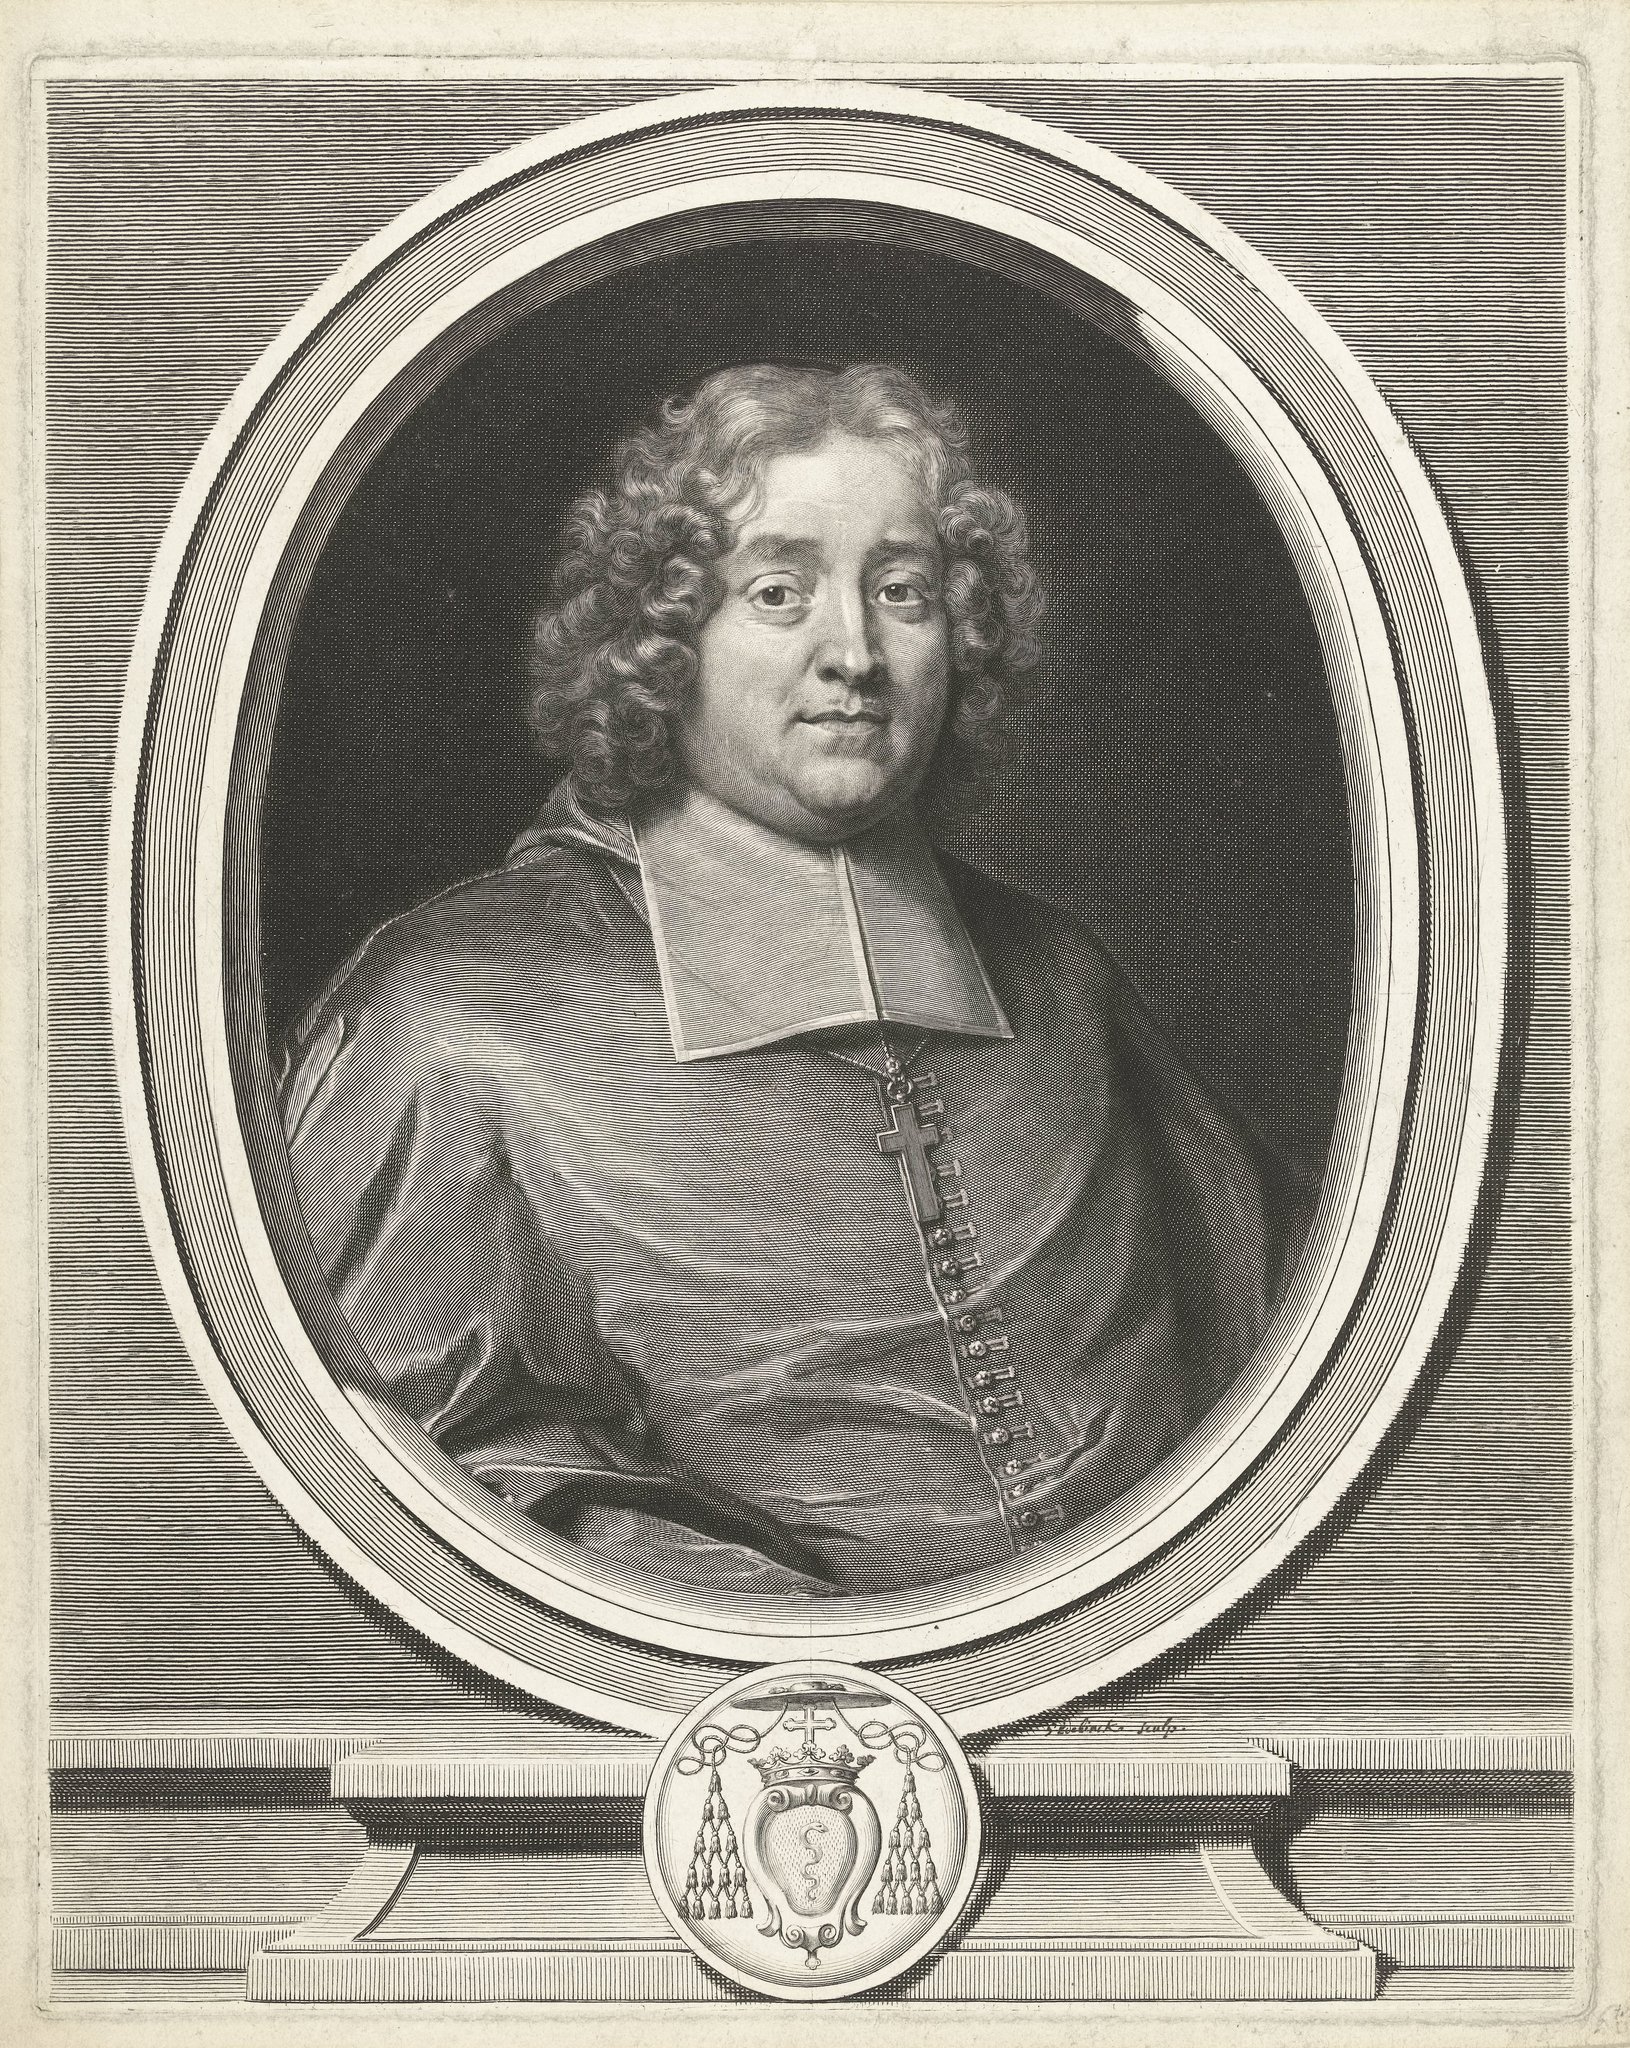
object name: print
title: Portret van Jean-Baptiste Michel Colbert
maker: gerard edelinck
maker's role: print maker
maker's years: 1640-1707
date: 1693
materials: paper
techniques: engraving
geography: france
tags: france, jean-baptiste michel colbert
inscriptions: collector's mark: Lugt 2228, inscription: ‘G Édelinck sculp.’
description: Portret van Jean-Baptiste Michel Colbert (1640-1710), aartsbisschop van Toulouse, afgebeeld in ovale omlijsting met wapen.